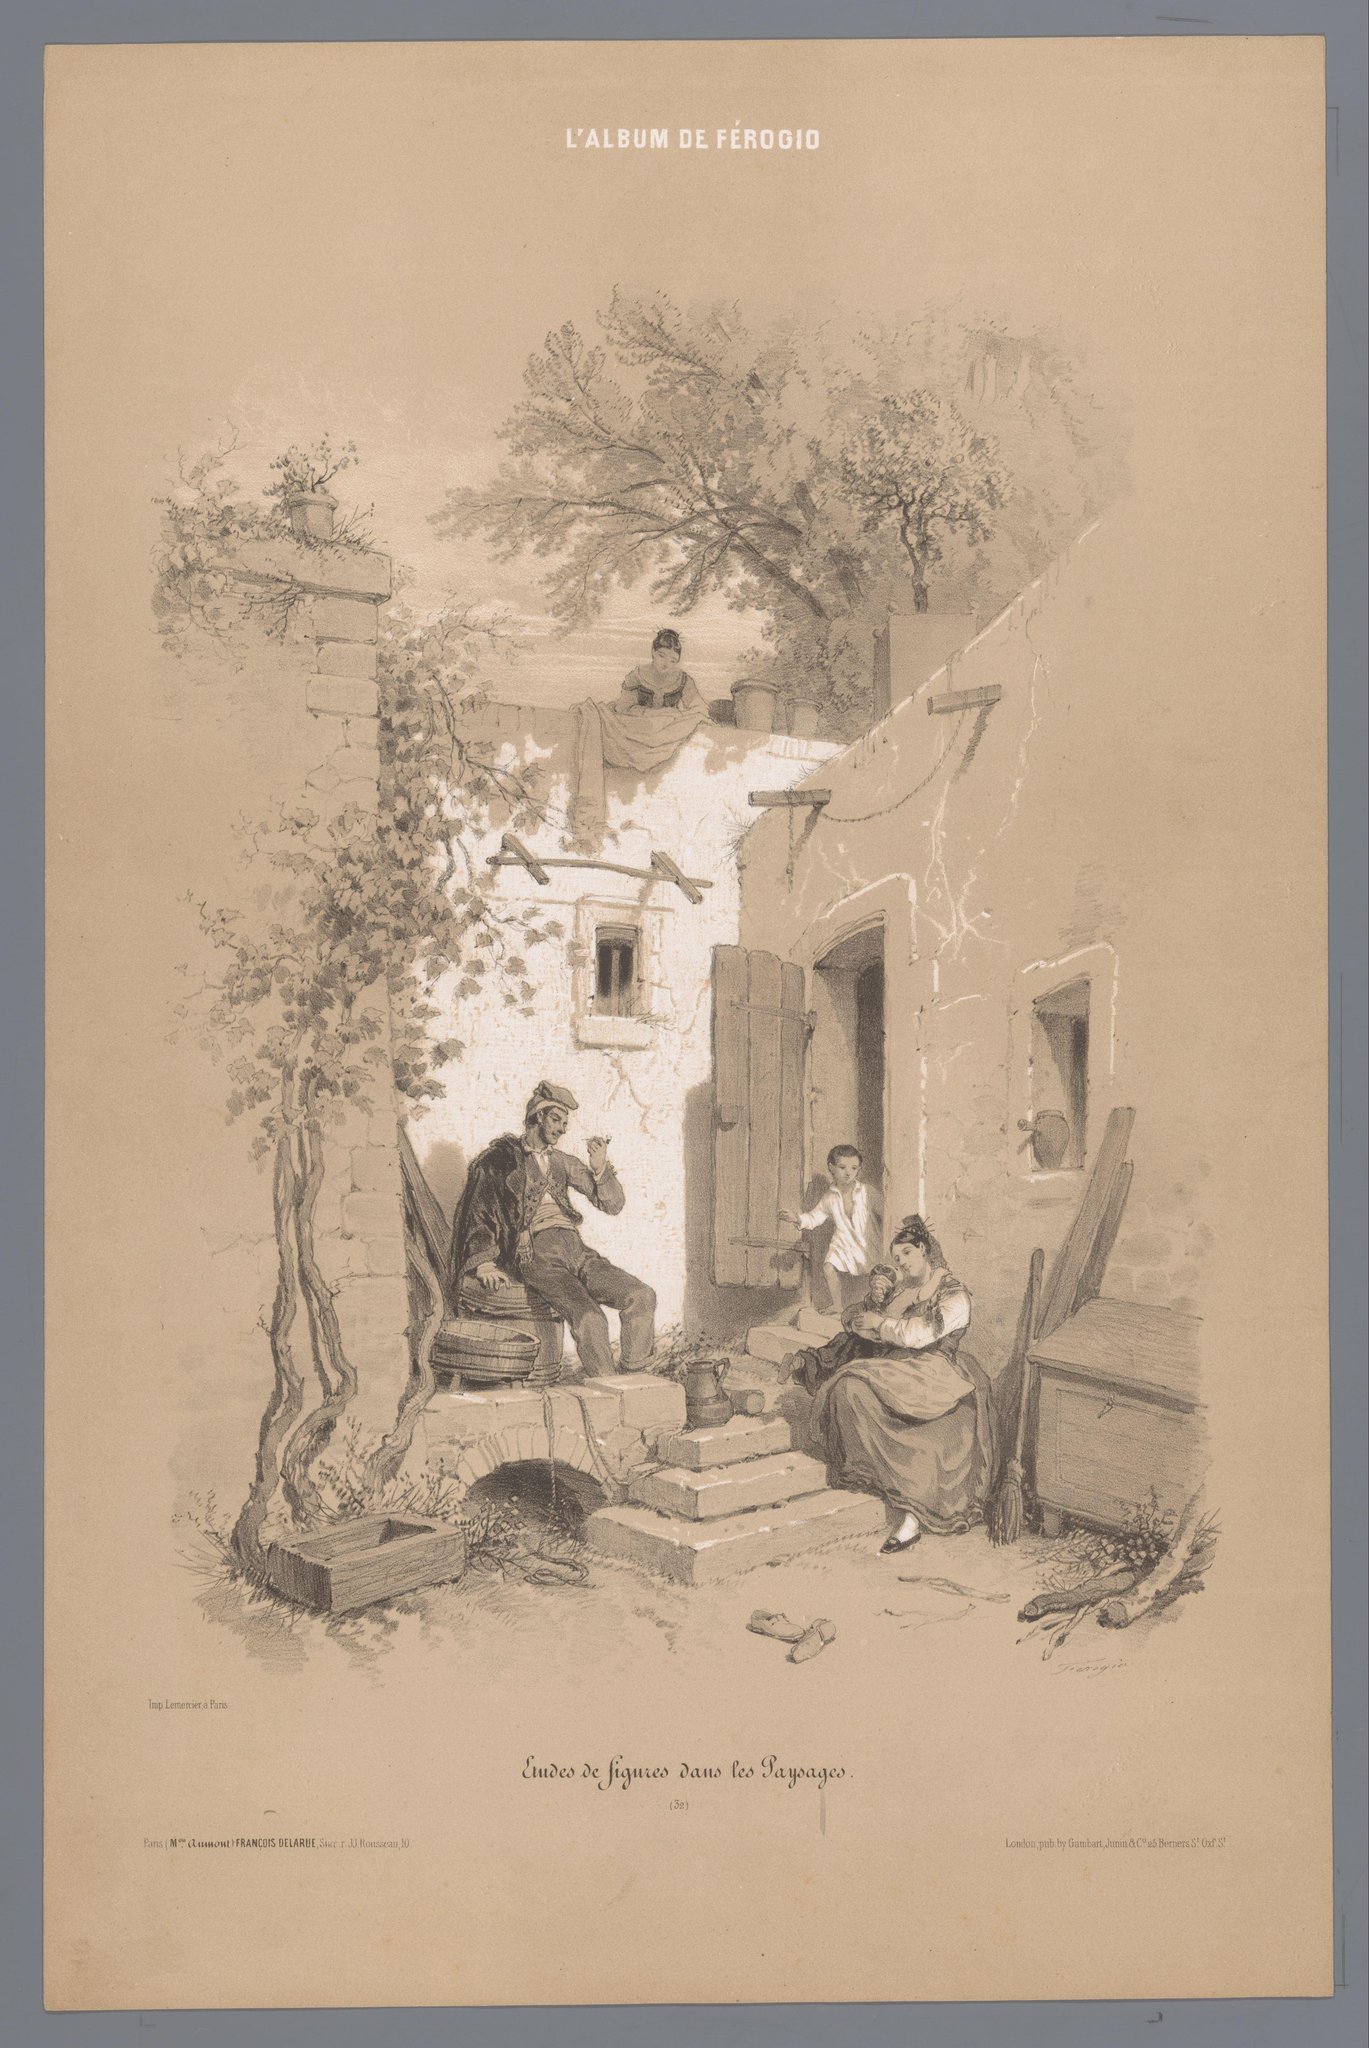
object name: print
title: Studies van figuren in een landschap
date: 1844-1854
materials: paper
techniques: tone lithography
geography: paris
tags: family group, especially parents with their child(ren), country dwellers, rural housing, e.g. country-house, villa, cottage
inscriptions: collector's mark: Lugt 2228a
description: Prent maakt deel uit van een omslag met zeven prenten.